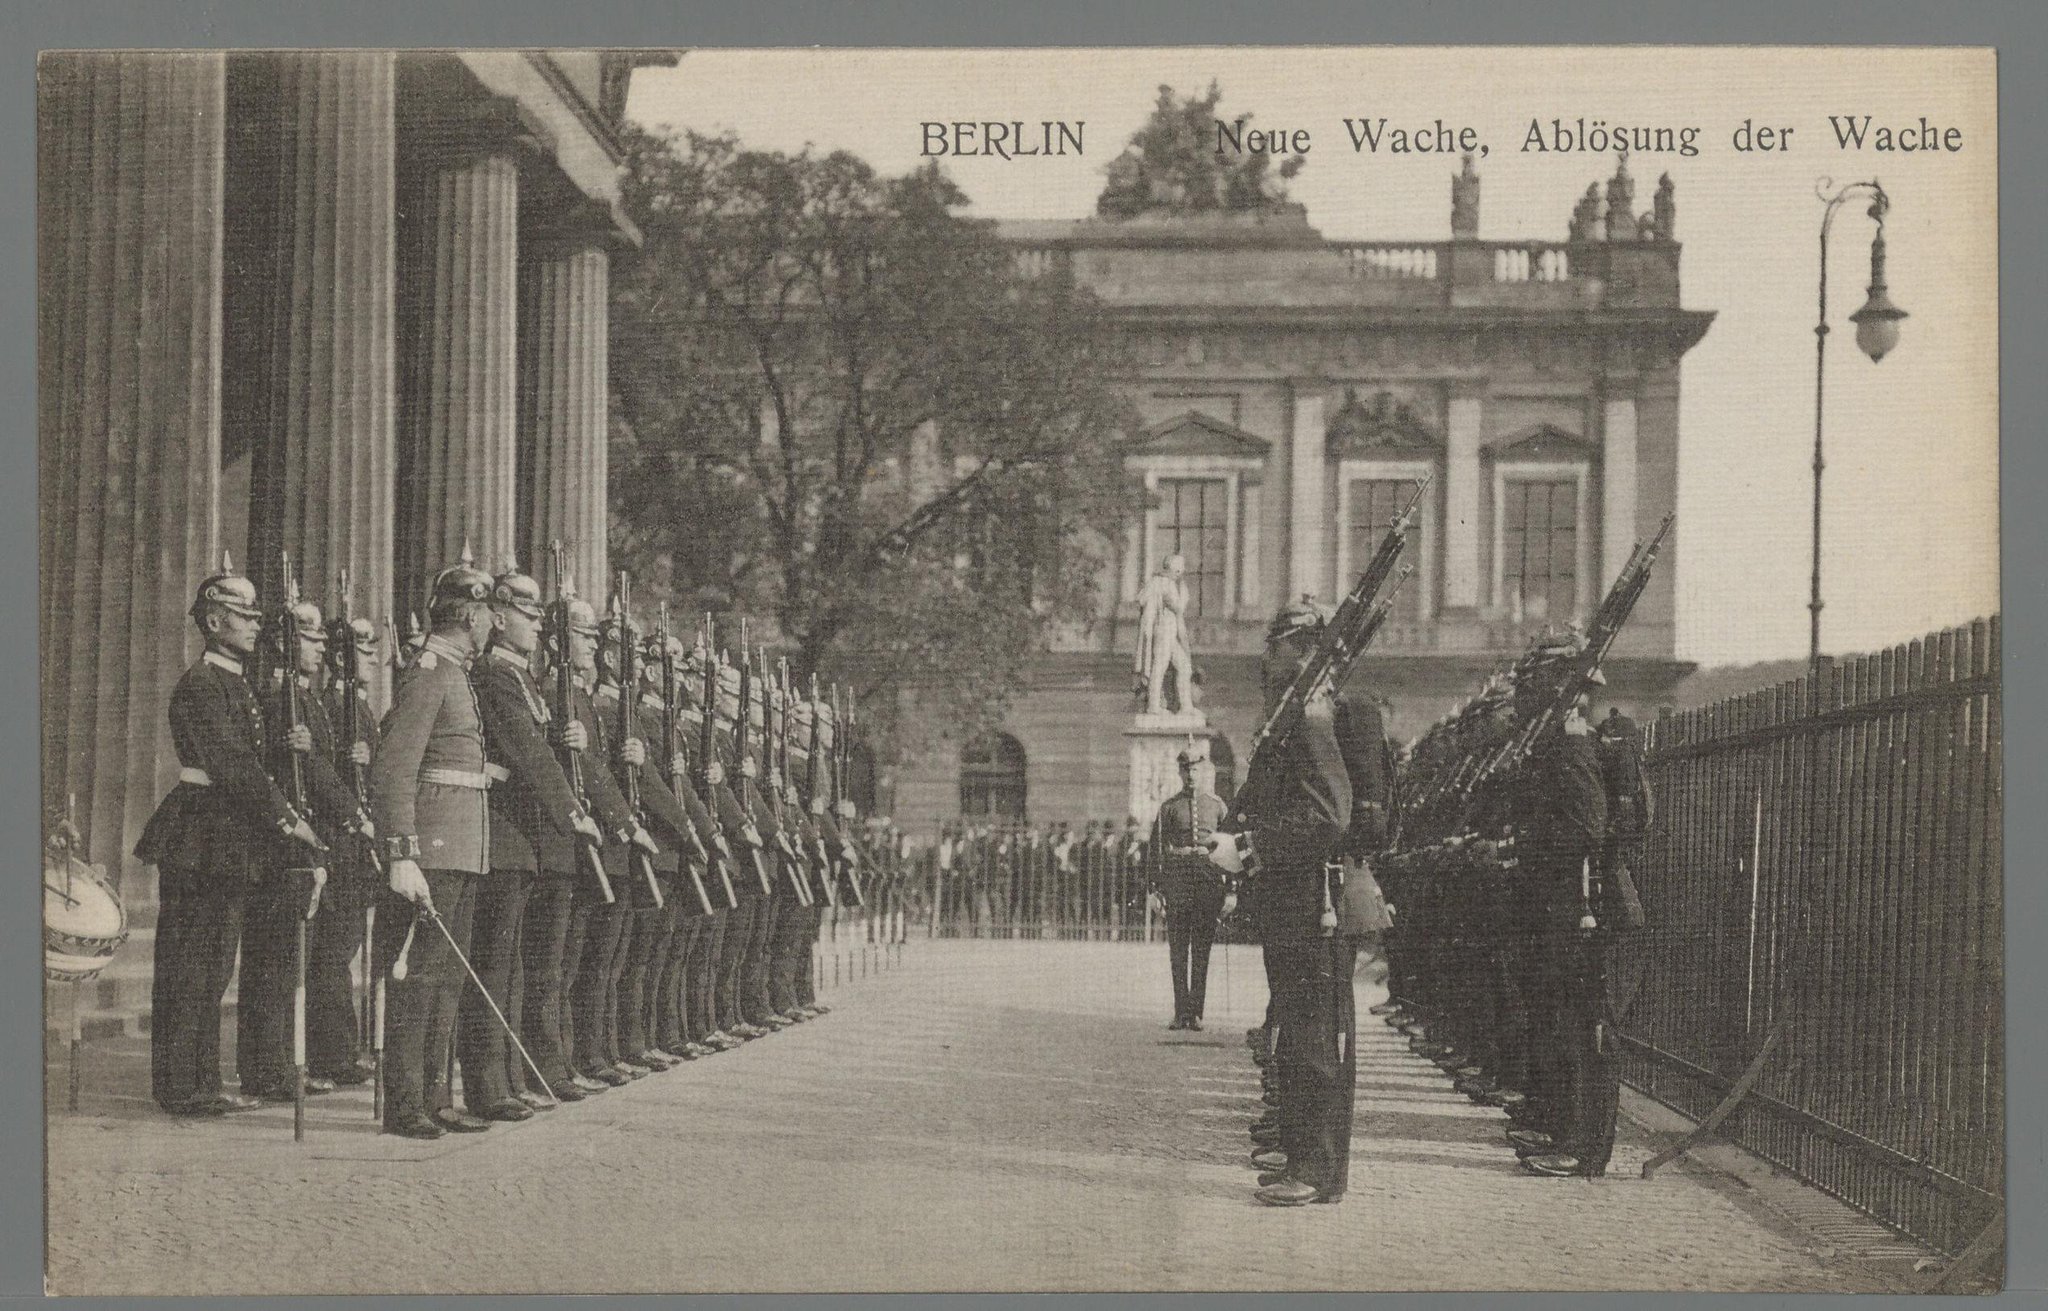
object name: ansichtkaart, prentbriefkaart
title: Berlin. Neue Wache, Ablösung der Wache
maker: Anonymous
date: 1905-1930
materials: cardboard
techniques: photograph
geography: berlin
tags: changing the guard, berlin